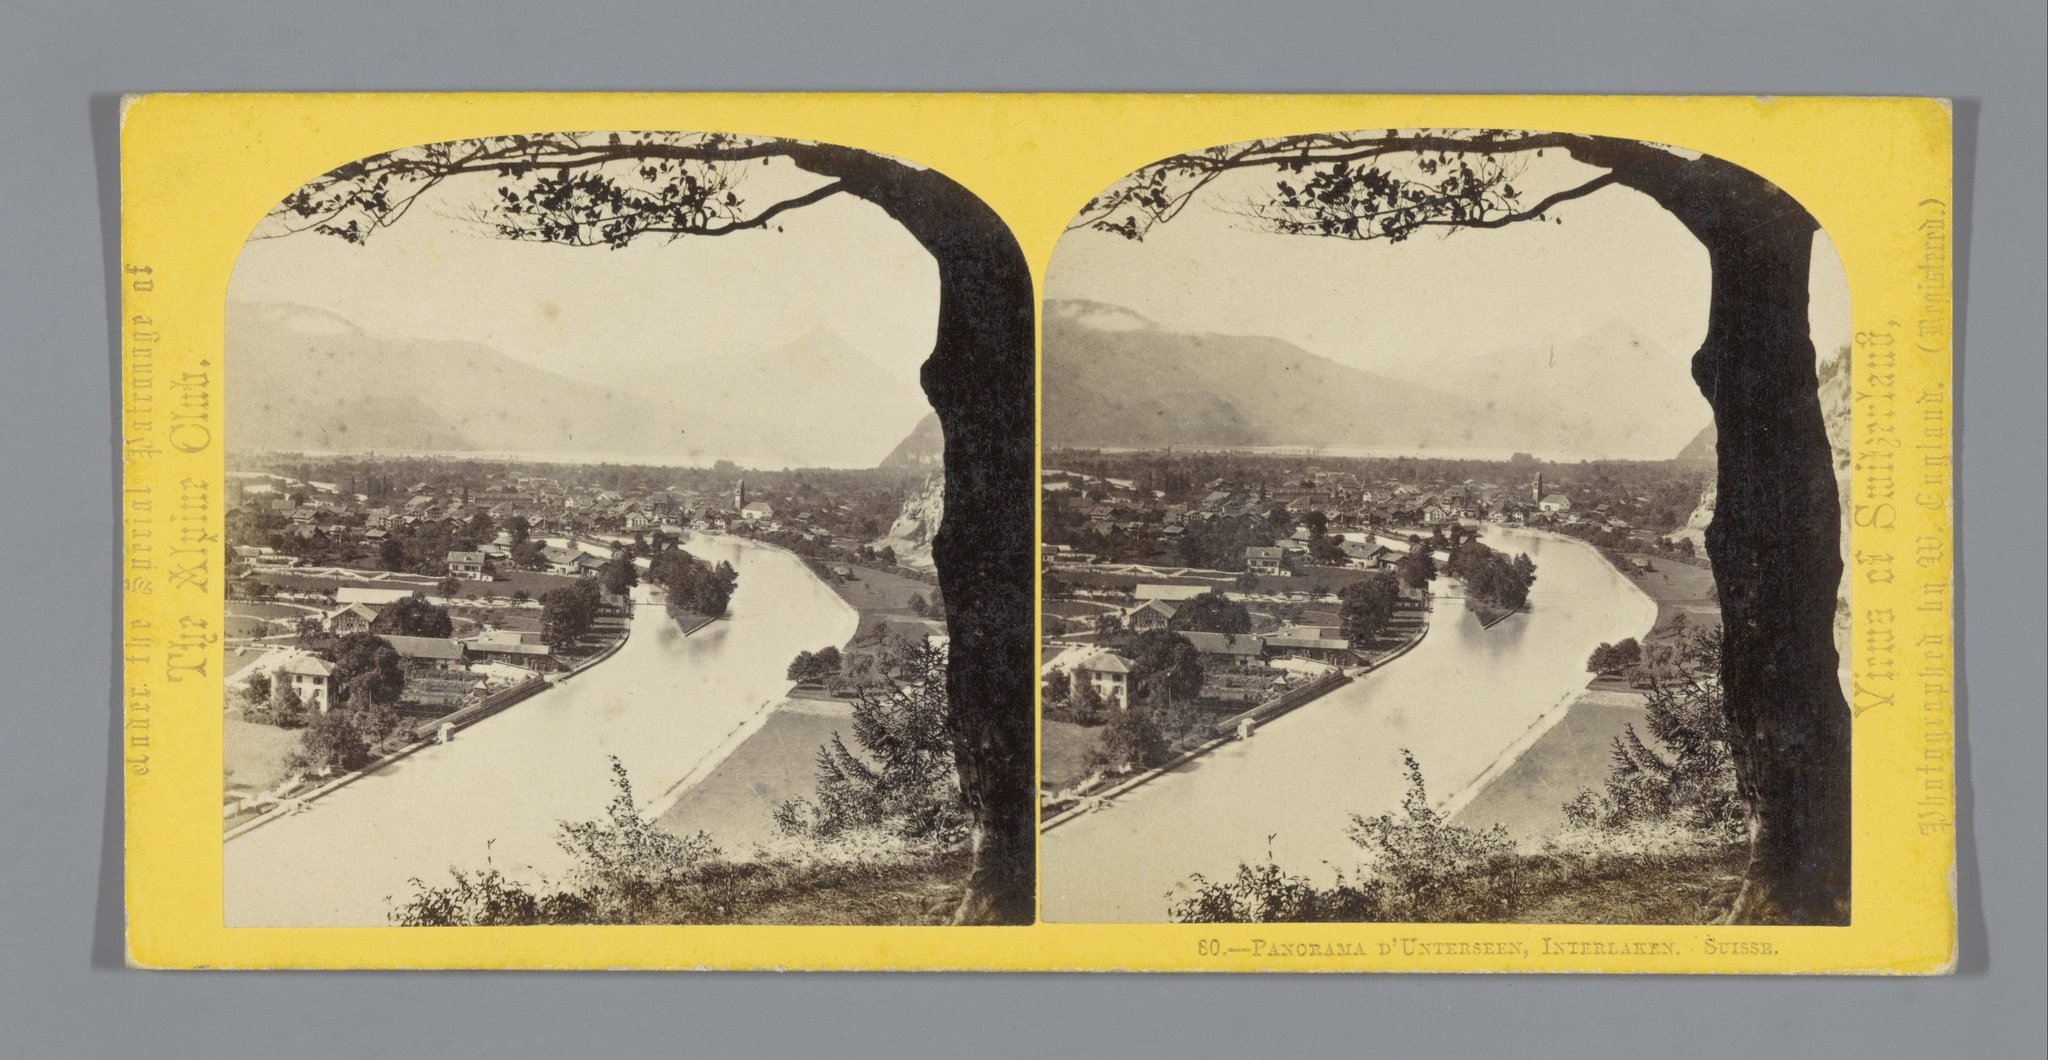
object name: stereograph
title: Panorama d'Unterseen, Interlaken. Suisse.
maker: william england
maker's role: fotograaf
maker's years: 1816-1896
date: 1850-1880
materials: cardboard, photographic support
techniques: albumen print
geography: bern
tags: city-view in general; 'veduta', river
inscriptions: number: ‘80.’, inscription: ‘Views of Switzerland, photographed by W. England. (Registered) Under the Special Patronage of the Alpine Club.’